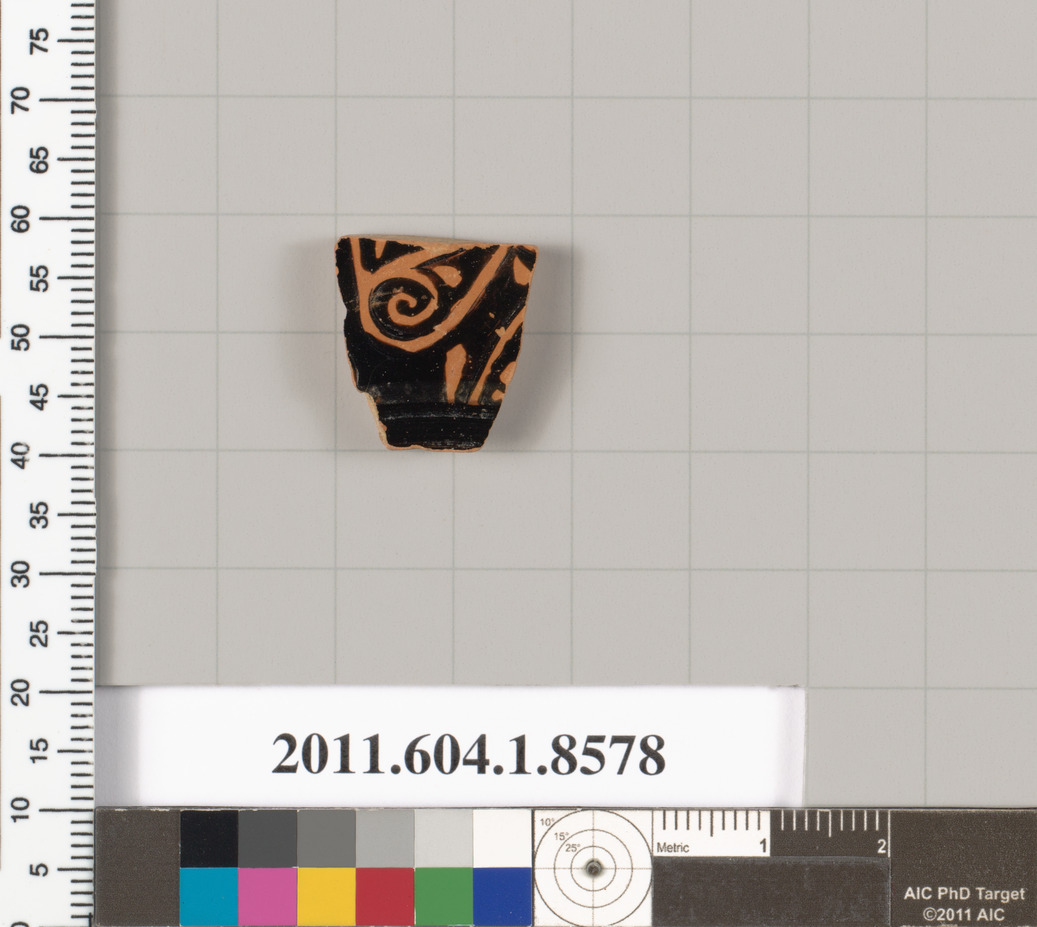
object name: kylix fragment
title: Terracotta fragment of a stemless kylix (drinking cup)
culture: greek, attic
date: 475-451 BCE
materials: terracotta